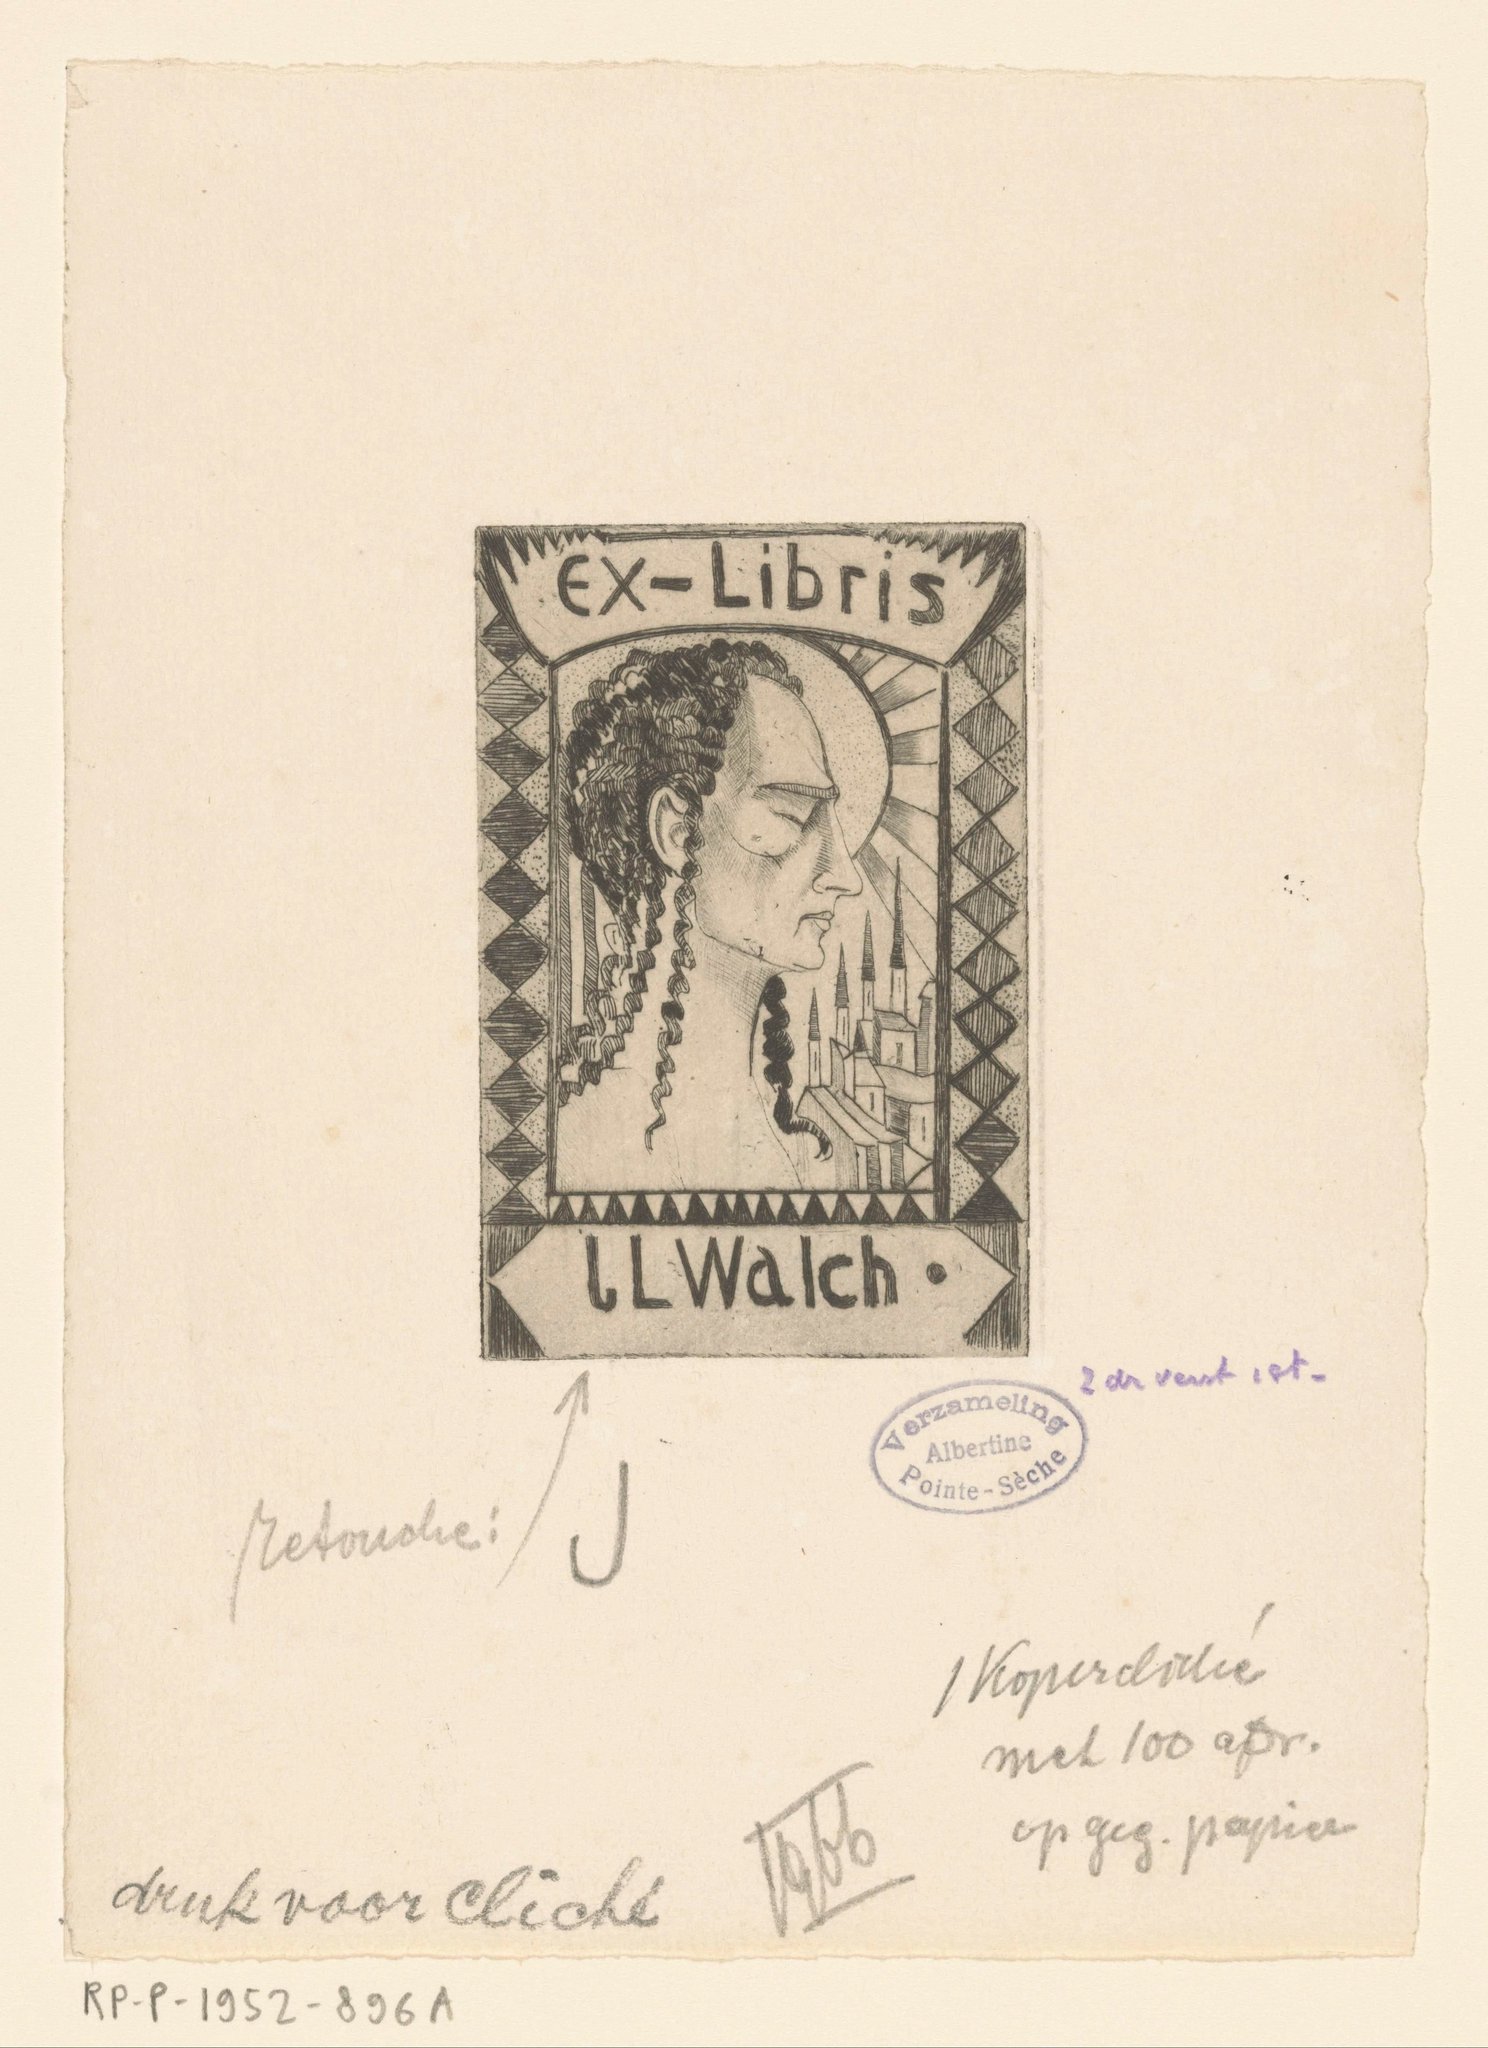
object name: bookplate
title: Ex libris van Jan Walch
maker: lodewijk schelfhout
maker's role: draughtsman, print maker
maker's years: 1881-1943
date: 1917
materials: paper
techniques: drypoint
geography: netherlands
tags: nimbus, halo ~ radiance emanating from persons or things, head (human) - aa - female human figure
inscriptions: collector's mark: Lugt 2760, collector's mark: Lugt 2228, collector's mark: Lugt 5i, inscription: ‘retouche: J / druk voor cliché / 1966 / 1 kopercliché met 100 afdr. op geg. papier’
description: Een figuur met aureool. Op de achtergrond gebouwen met torens.